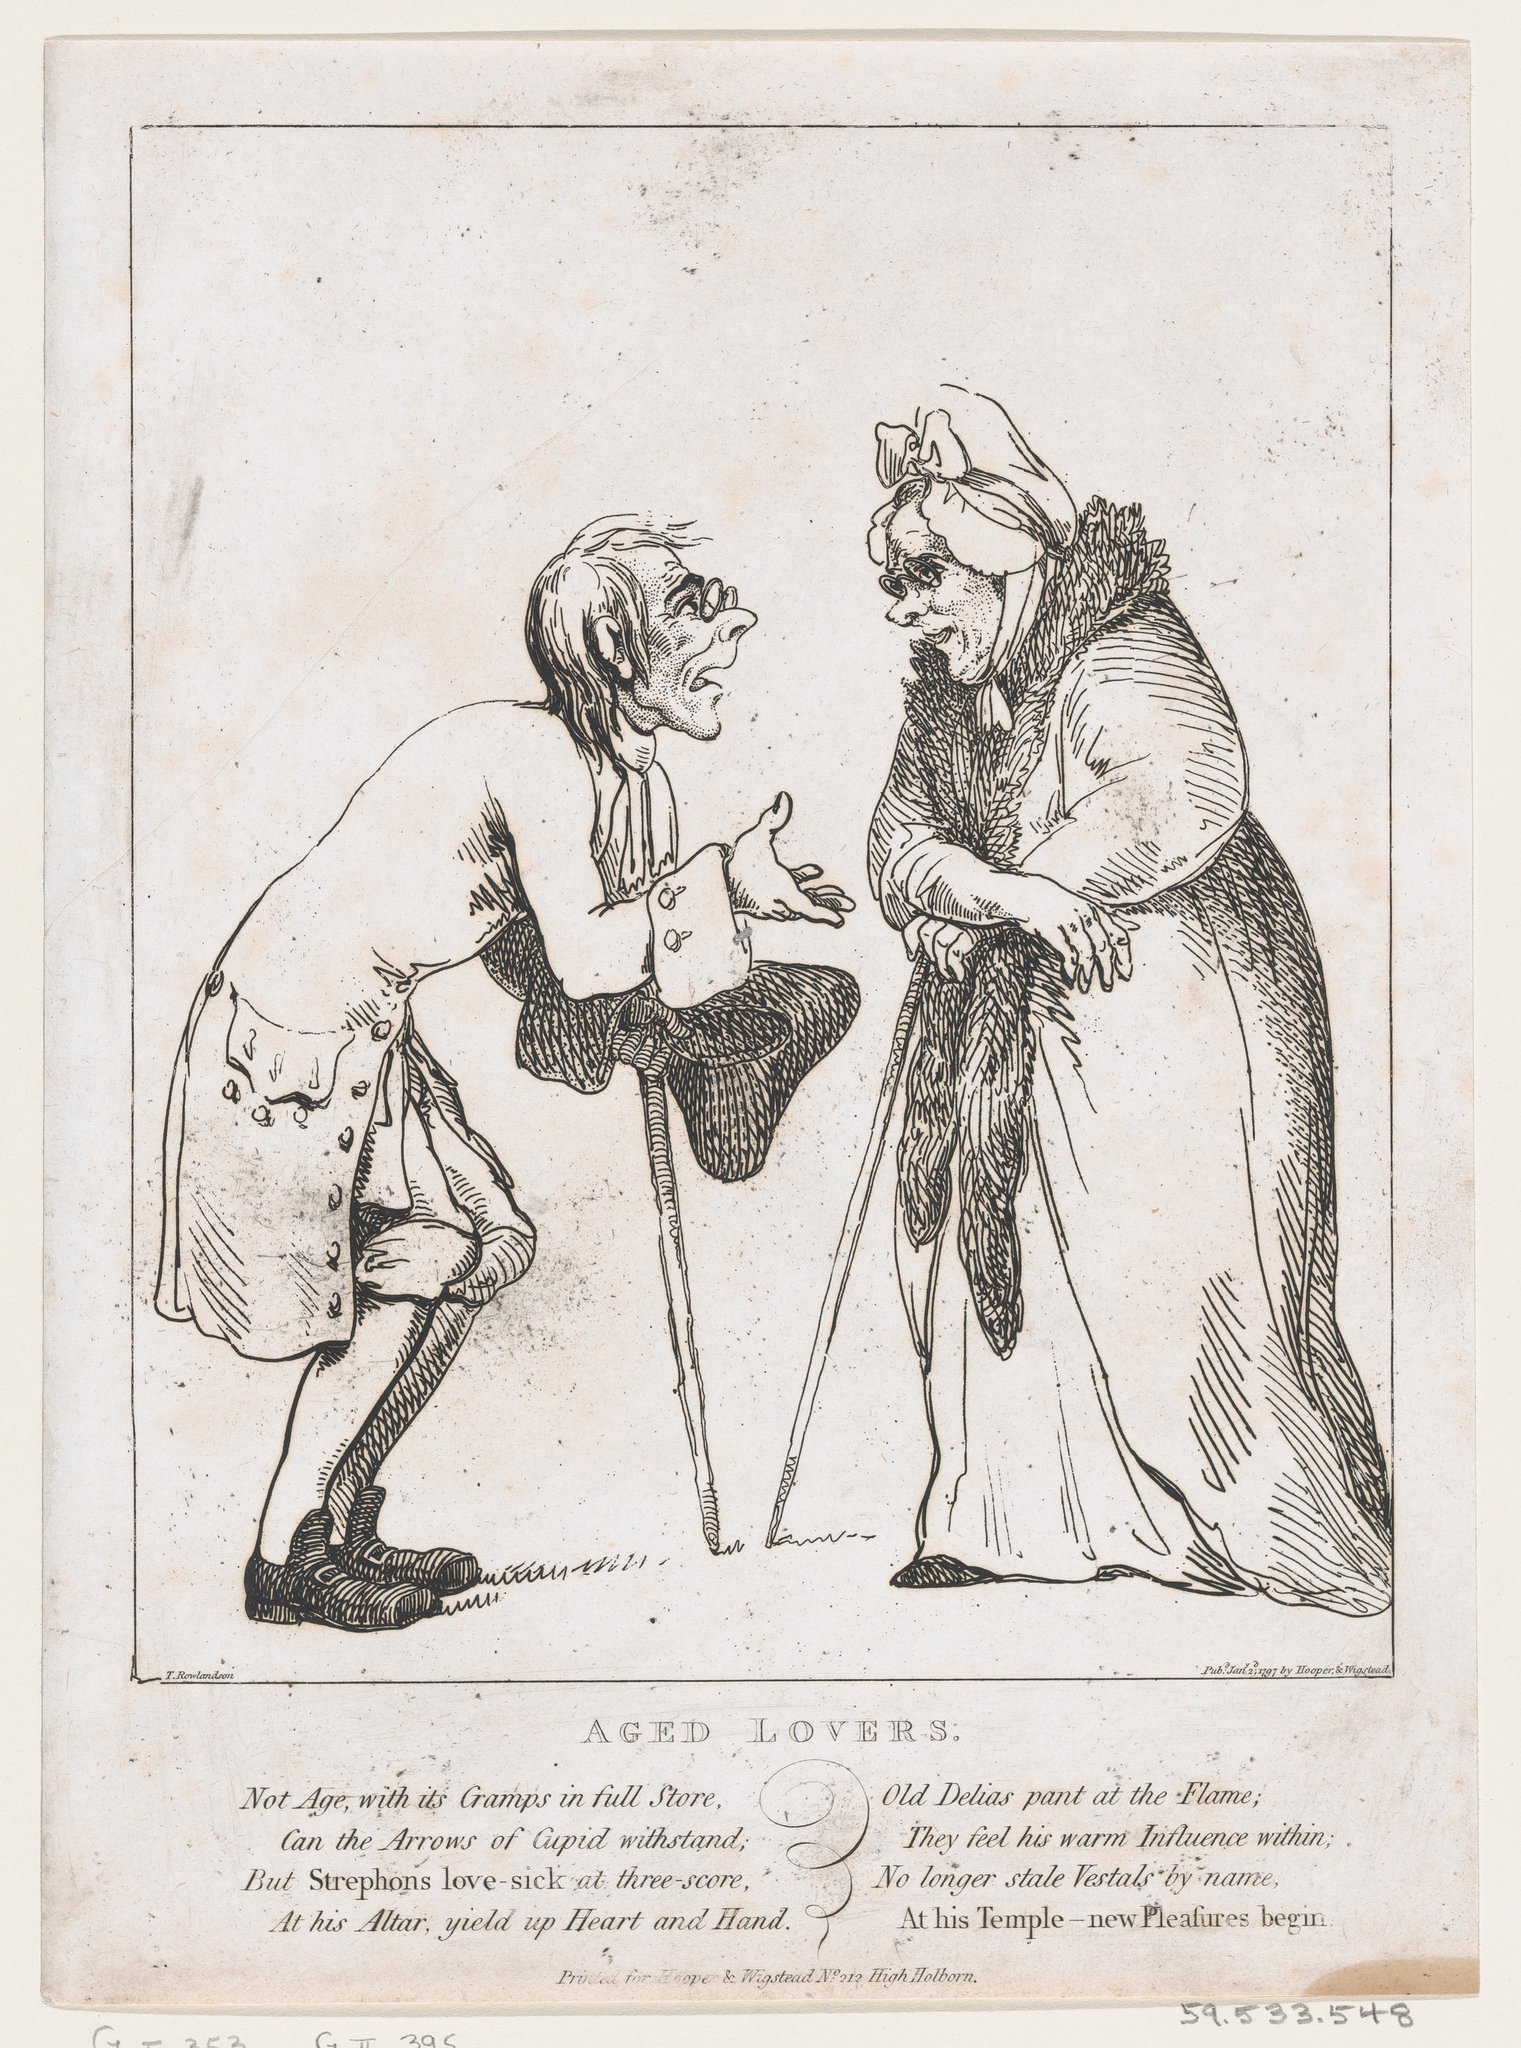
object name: print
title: Aged Lovers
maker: thomas rowlandson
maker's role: artist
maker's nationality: british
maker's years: 1757-1827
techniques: etching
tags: men,lovers,women